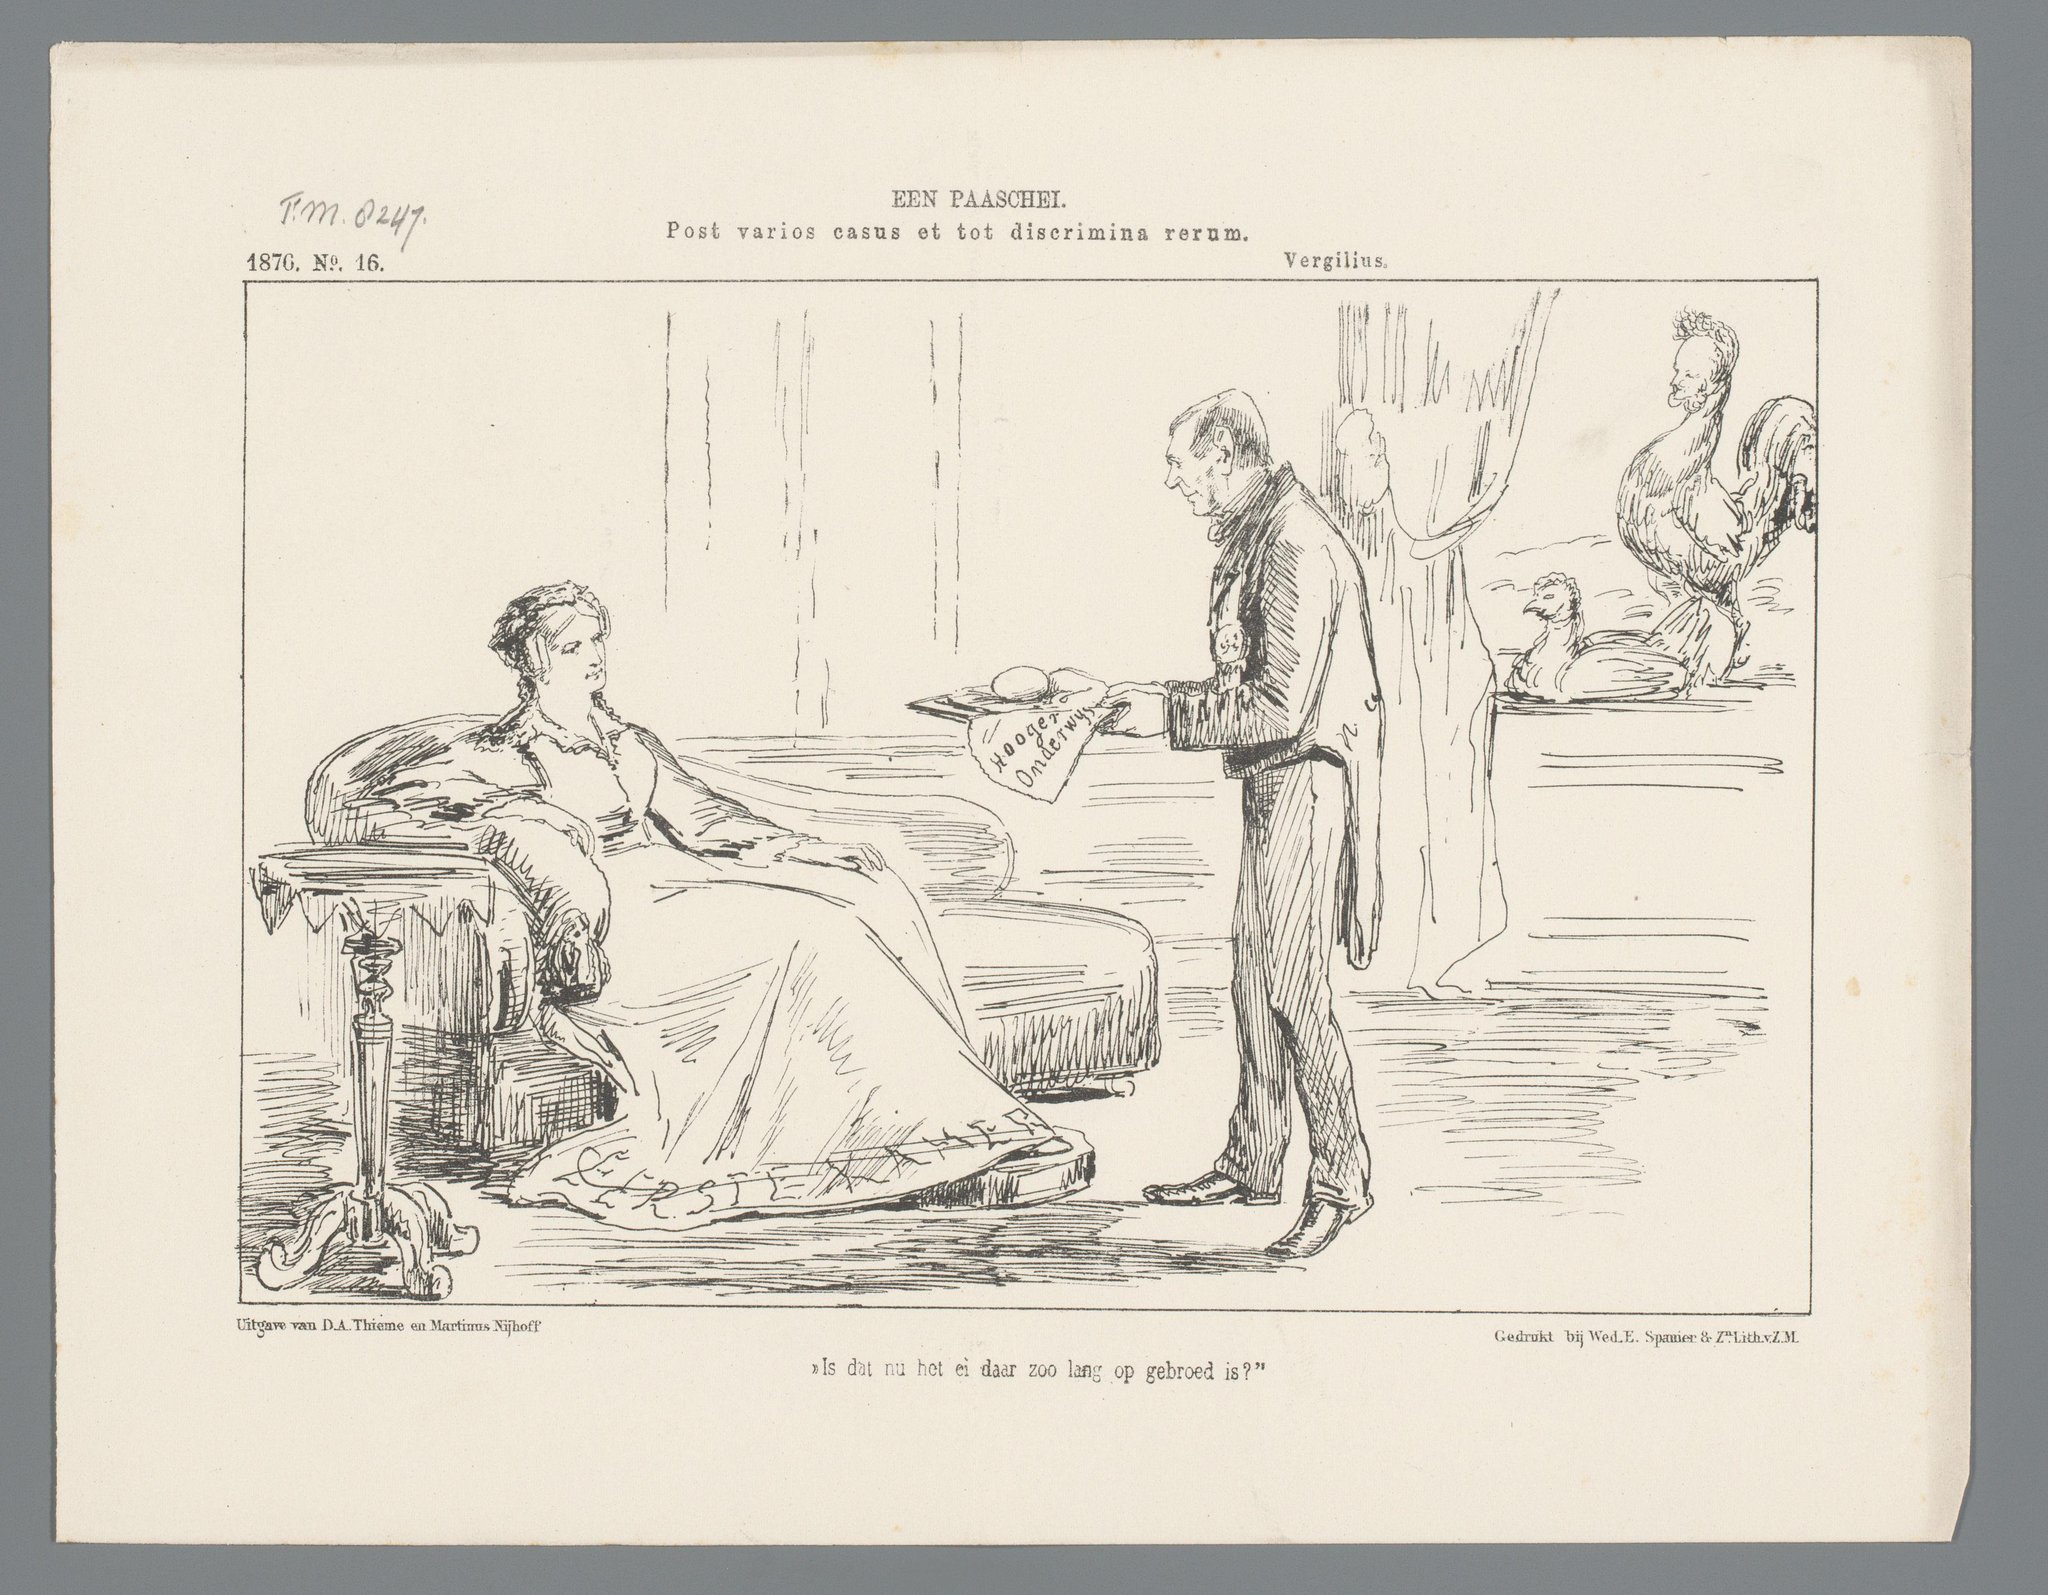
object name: cartoon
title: Spotprent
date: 1876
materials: paper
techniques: lithograph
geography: netherlands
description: Spotprent . Plaat verschenen bij het weekblad De Nederlandsche Spectator, nr. 16, 1876.